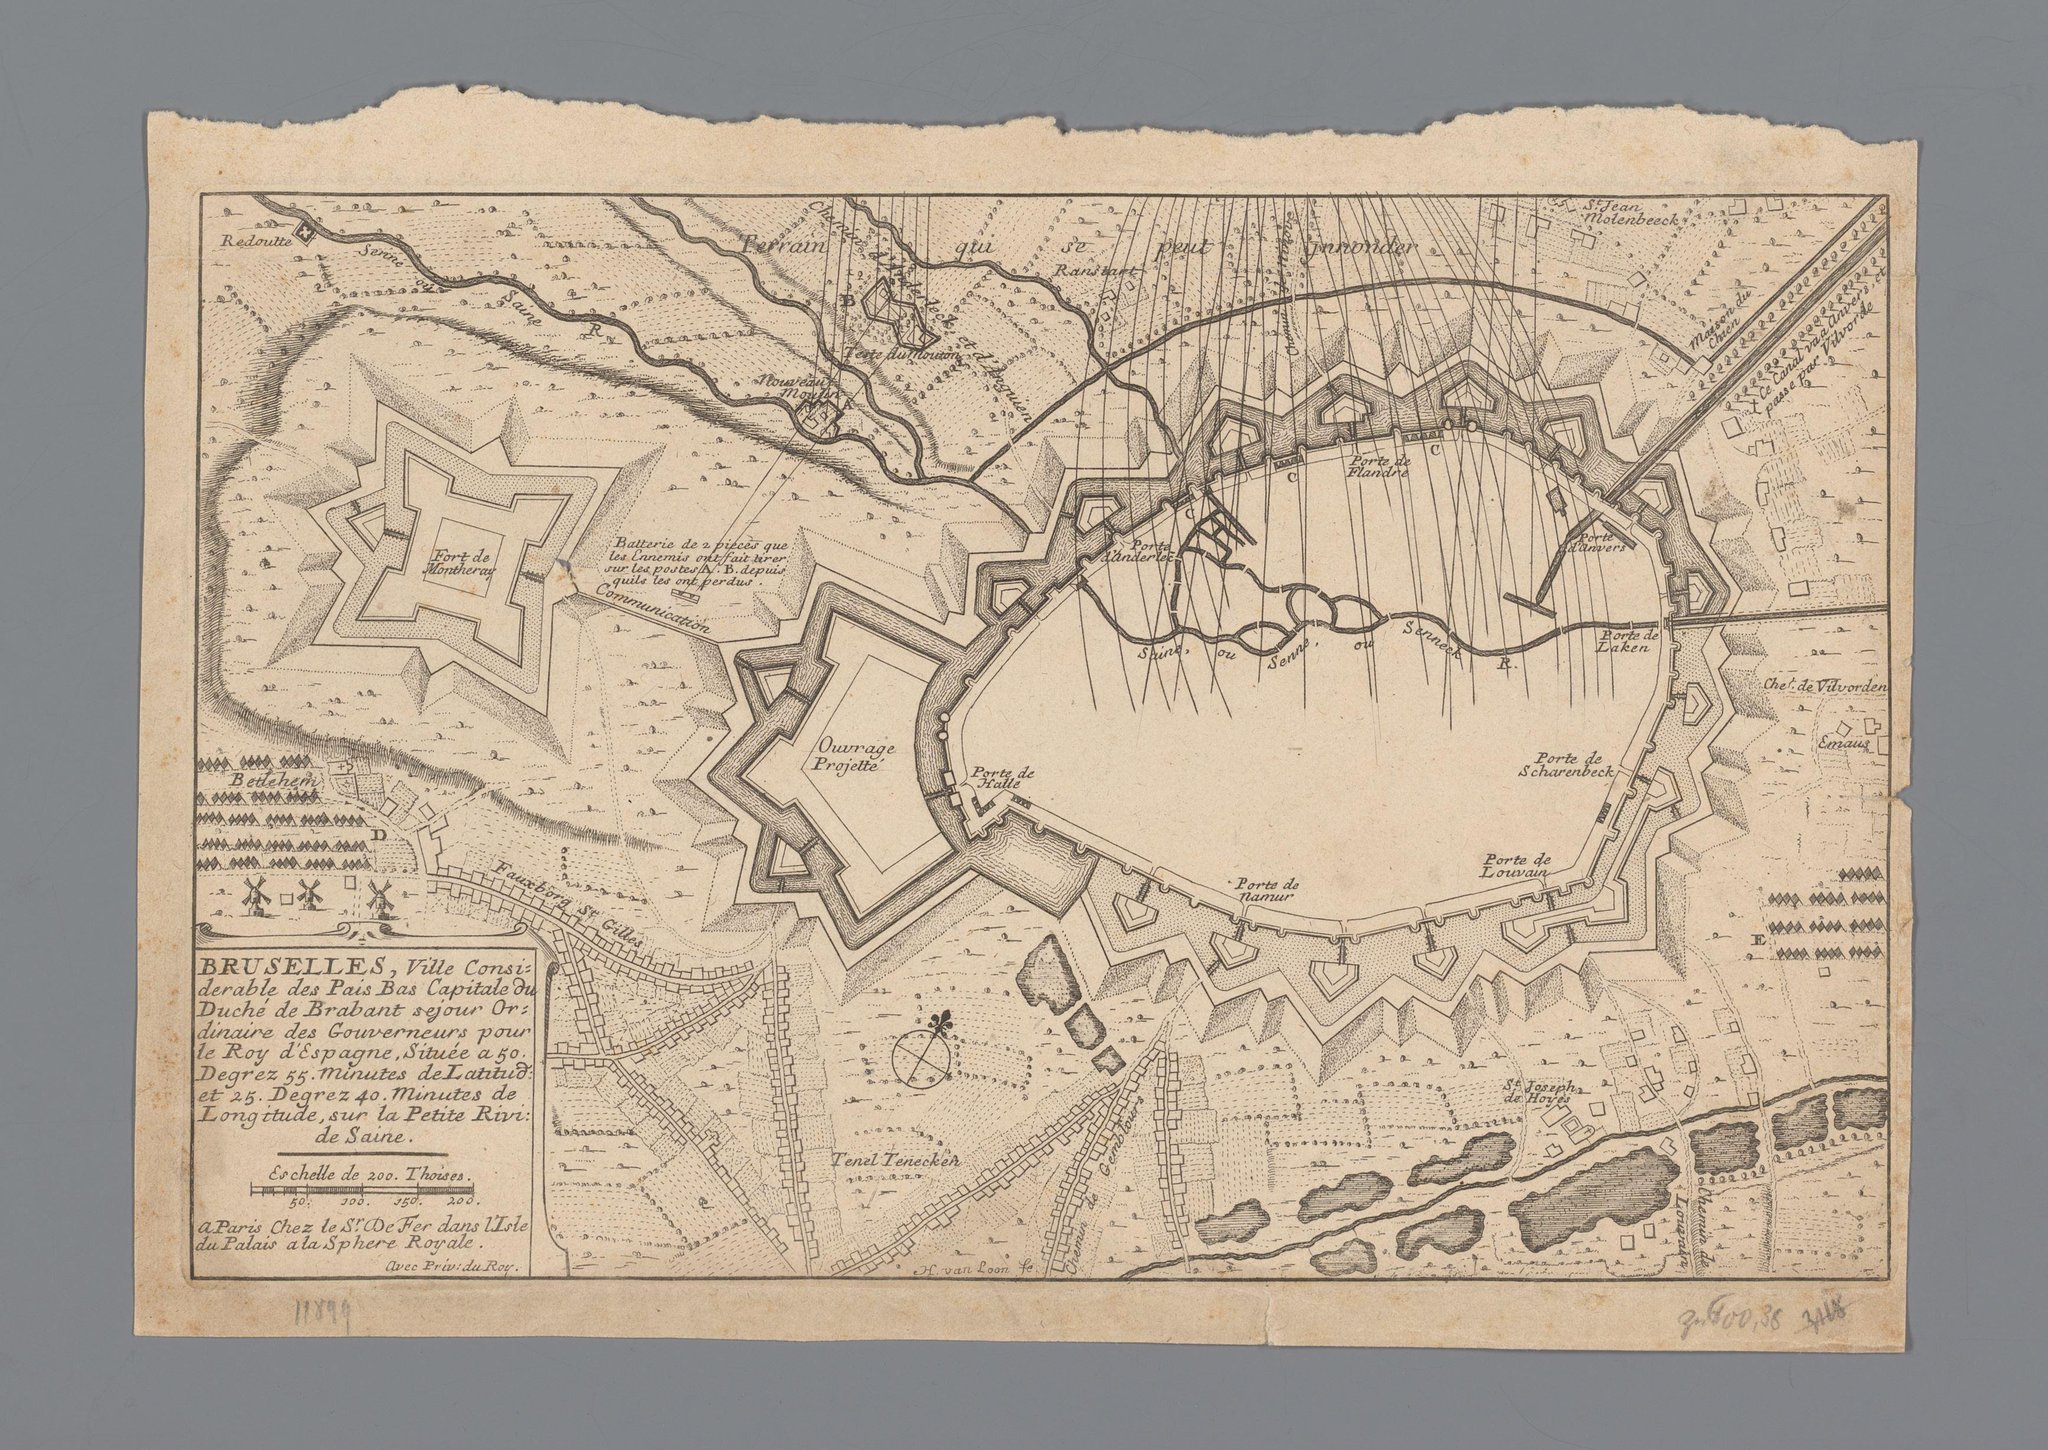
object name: print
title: Bruselles, ville considerable des Pais Bas Capitale du Duché de Brabant (...)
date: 1690-1695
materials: paper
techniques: etching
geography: paris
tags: maps of cities, brussels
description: Prent uit: Les forces de l'Europe. Parijs: Nicolas De Fer, 1690-1695.